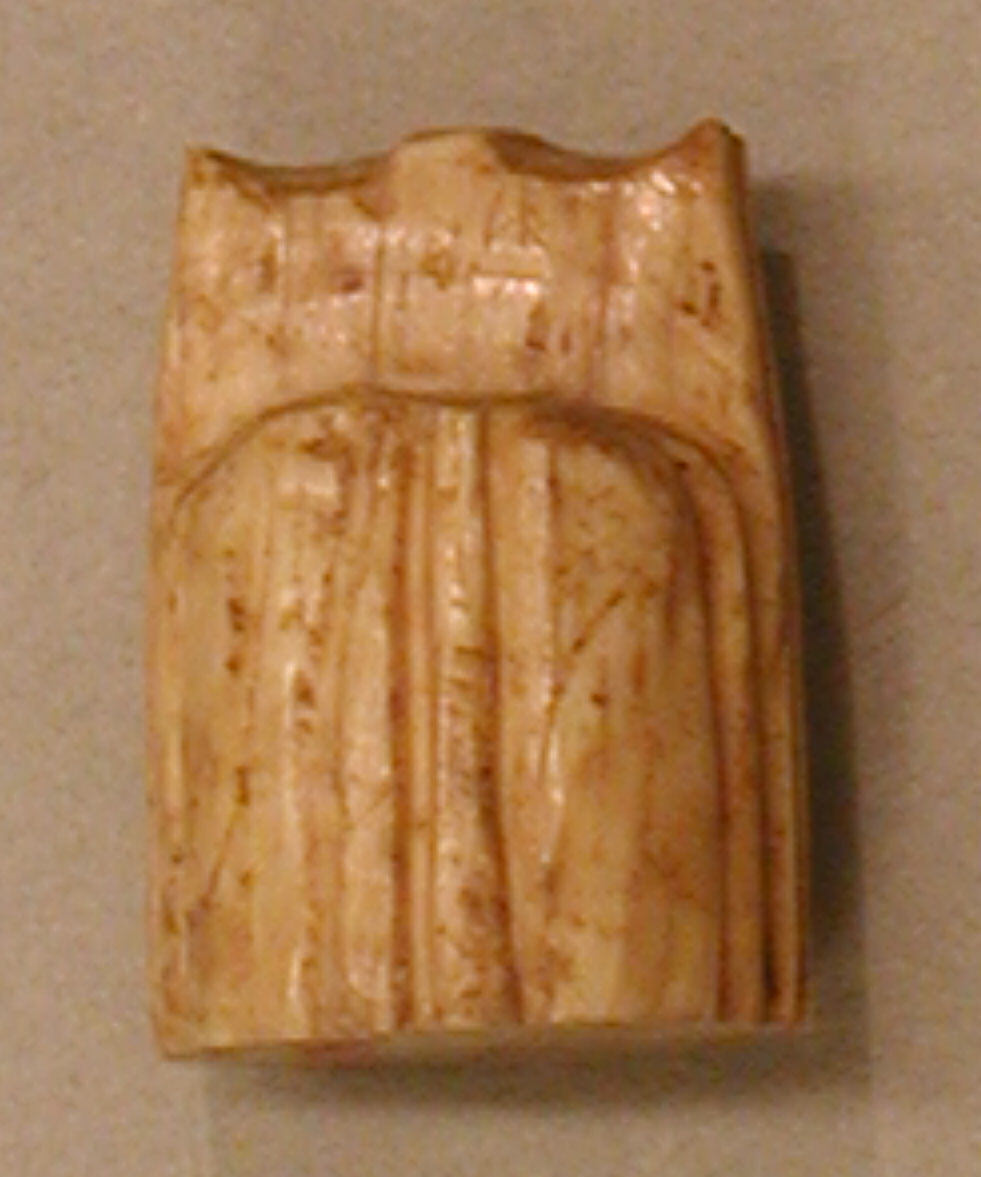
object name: chess piece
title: Chess Piece, King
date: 801-1200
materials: ivory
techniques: carving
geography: iran